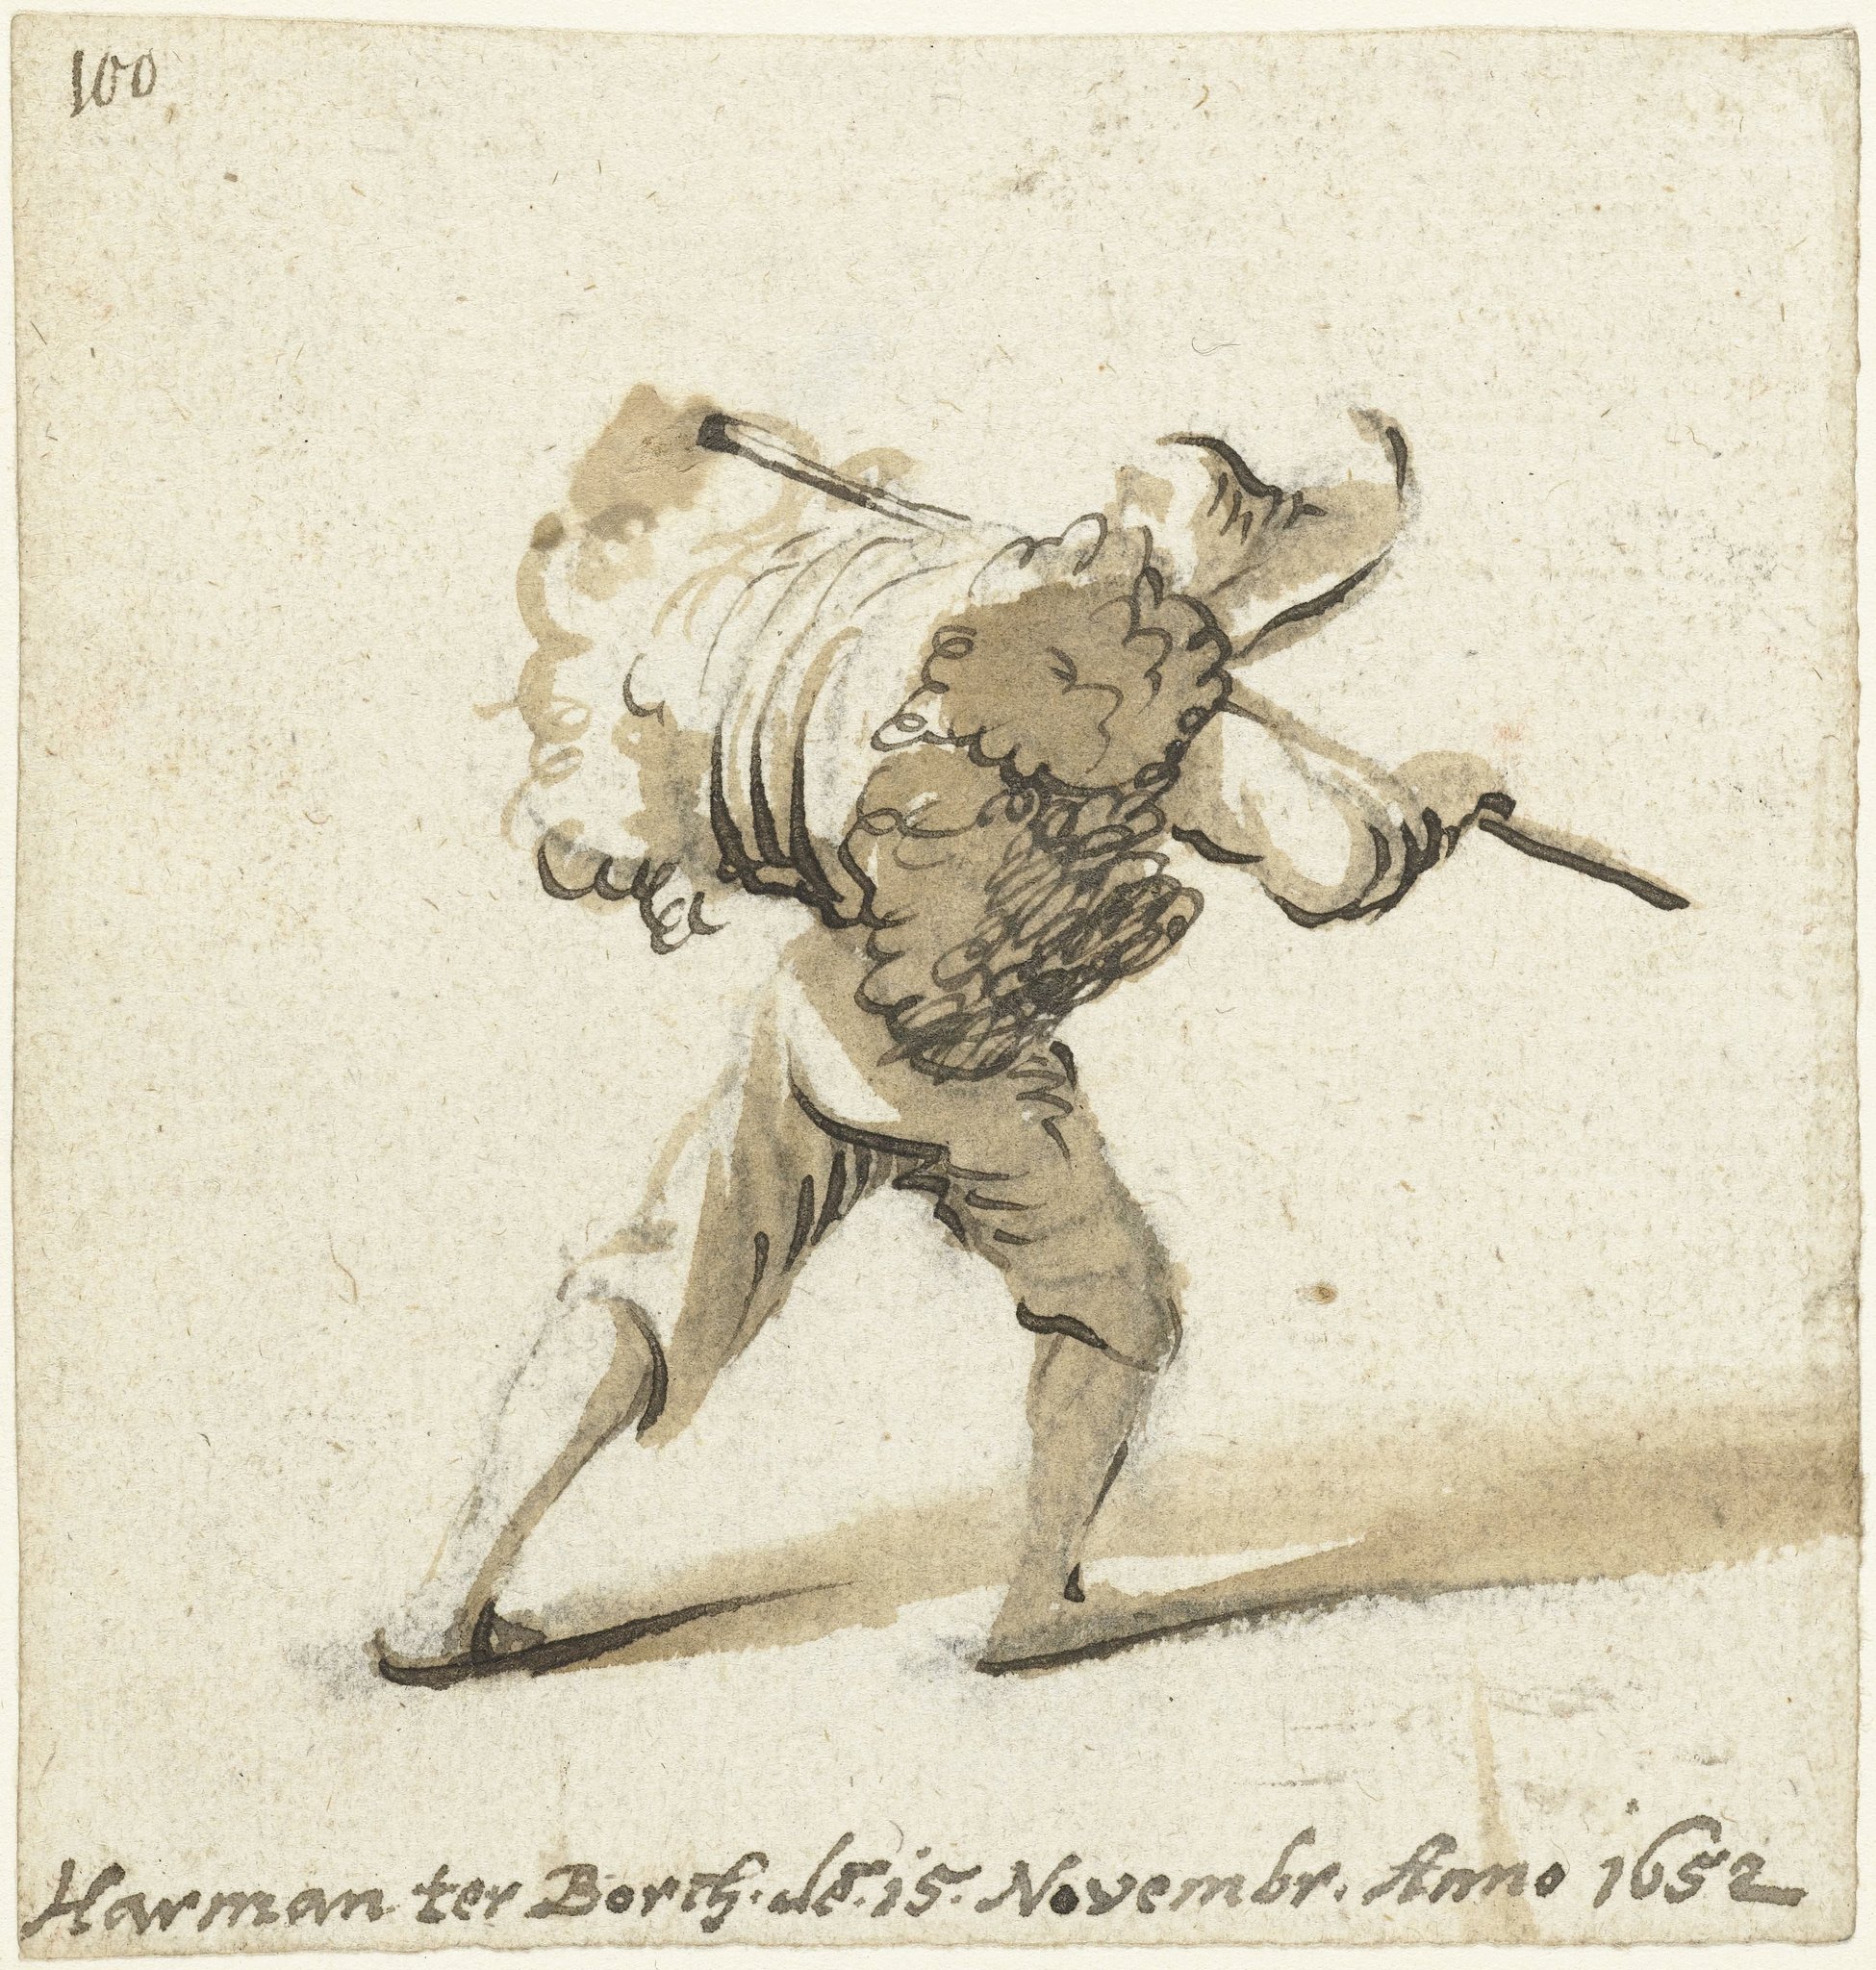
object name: drawing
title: Man met baal wol op zijn rug, van achteren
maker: harmen ter borch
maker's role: draughtsman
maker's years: 1638-1677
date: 1652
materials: chalk, ink, paper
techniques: brush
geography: zwolle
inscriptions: annotation: ‘Harman ter Borch.de[n].15.Novembr. Anno 1652’